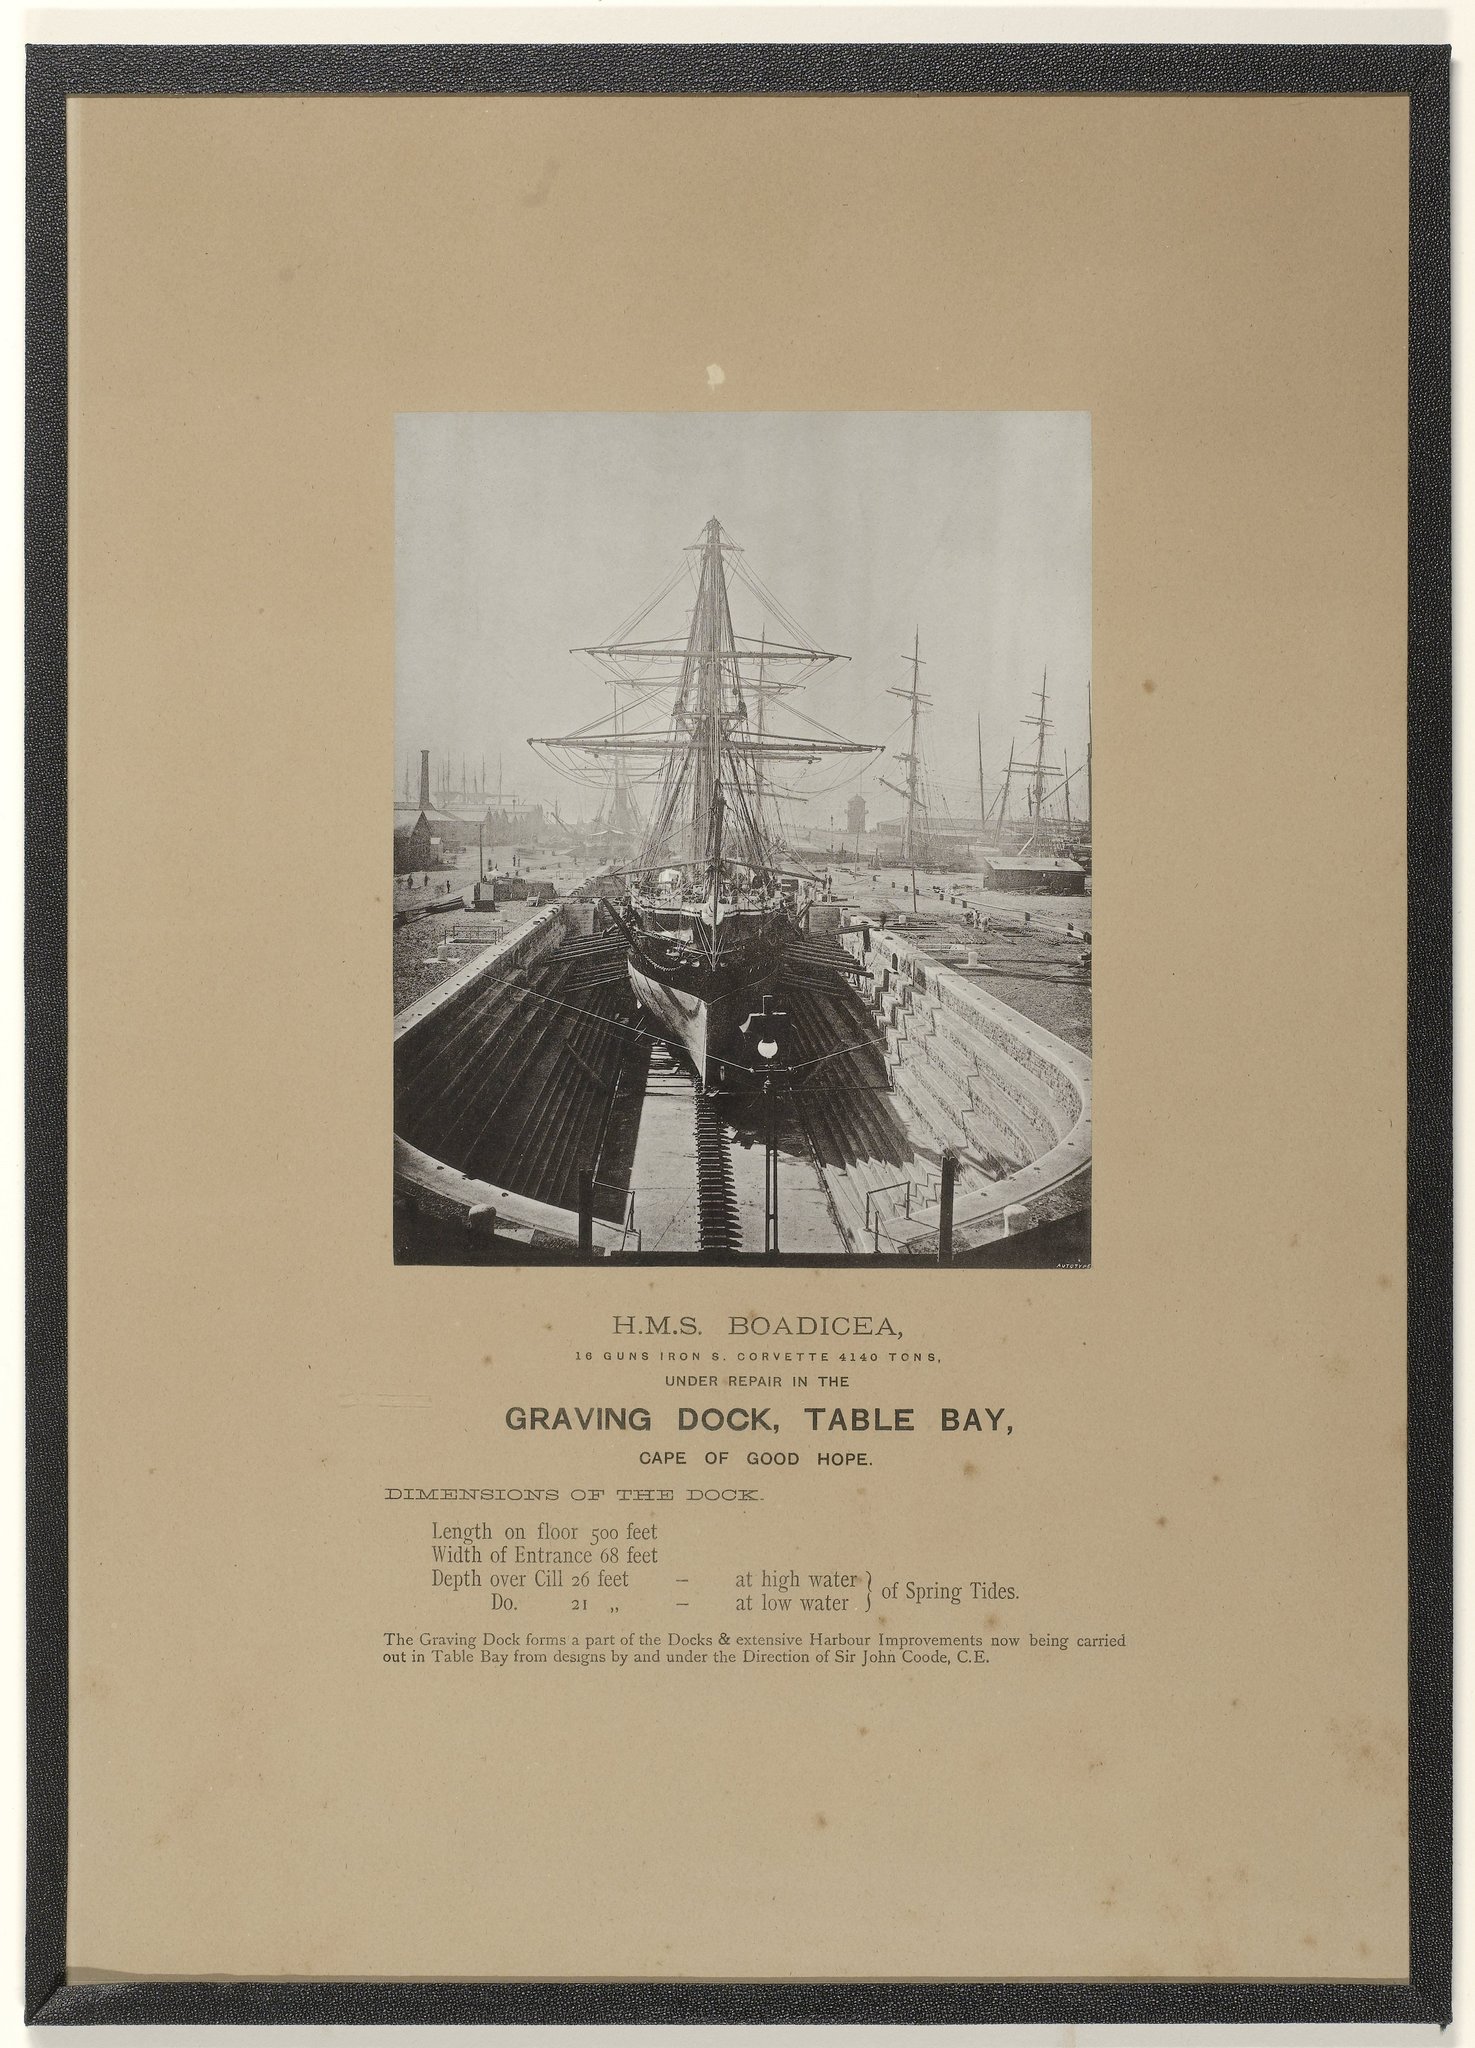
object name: photograph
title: HMS Boadicea, under repair in the graving dock, Table Bay, Cape of Good Hope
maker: Anonymous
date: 1875-1900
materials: cardboard, glass, paper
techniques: photograph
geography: cape of good hope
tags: cape of good hope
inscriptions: inscription: ‘AUTOTYPE’, inscription: ‘H.M.S. BOADICEA, 16 GUNS IRON S, CORVETTE 4140 TONS UNDER REPAIR IN THE GRAVING DOCK, TABLE BAY, CAPE OF GOOD HOPE. DIMENSIONS OF THE DOCK. Length on floor 500 feet Width of Entrance 68 feet Depth over Cill 26 feet - at high water of Spring tides Do. 21 feet - at low water of Spring tides The graving Dock forms a part of the Docks & extensive Harbour Improvements now being carried out in Table Bay from designs by and under the Directions of Sir John Cood, C.E.’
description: Ingelijste zwart-wit foto van HMS Boadicea, ter reparatie in het droogdok in Table Bay, Kaap de Goede Hoop. Geplakt op papier. Onder de foto opschrift.